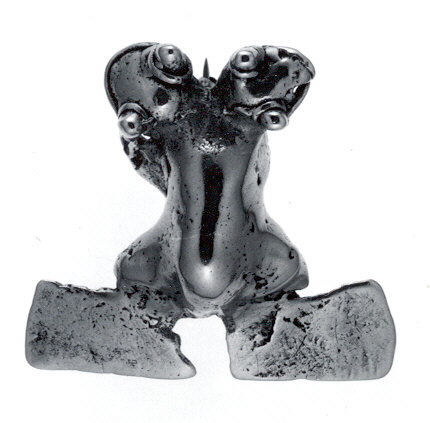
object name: pendant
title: Gold Double-Headed Frog Ornament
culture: chiriqui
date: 1001-1600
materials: gold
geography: costa rica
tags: frogs